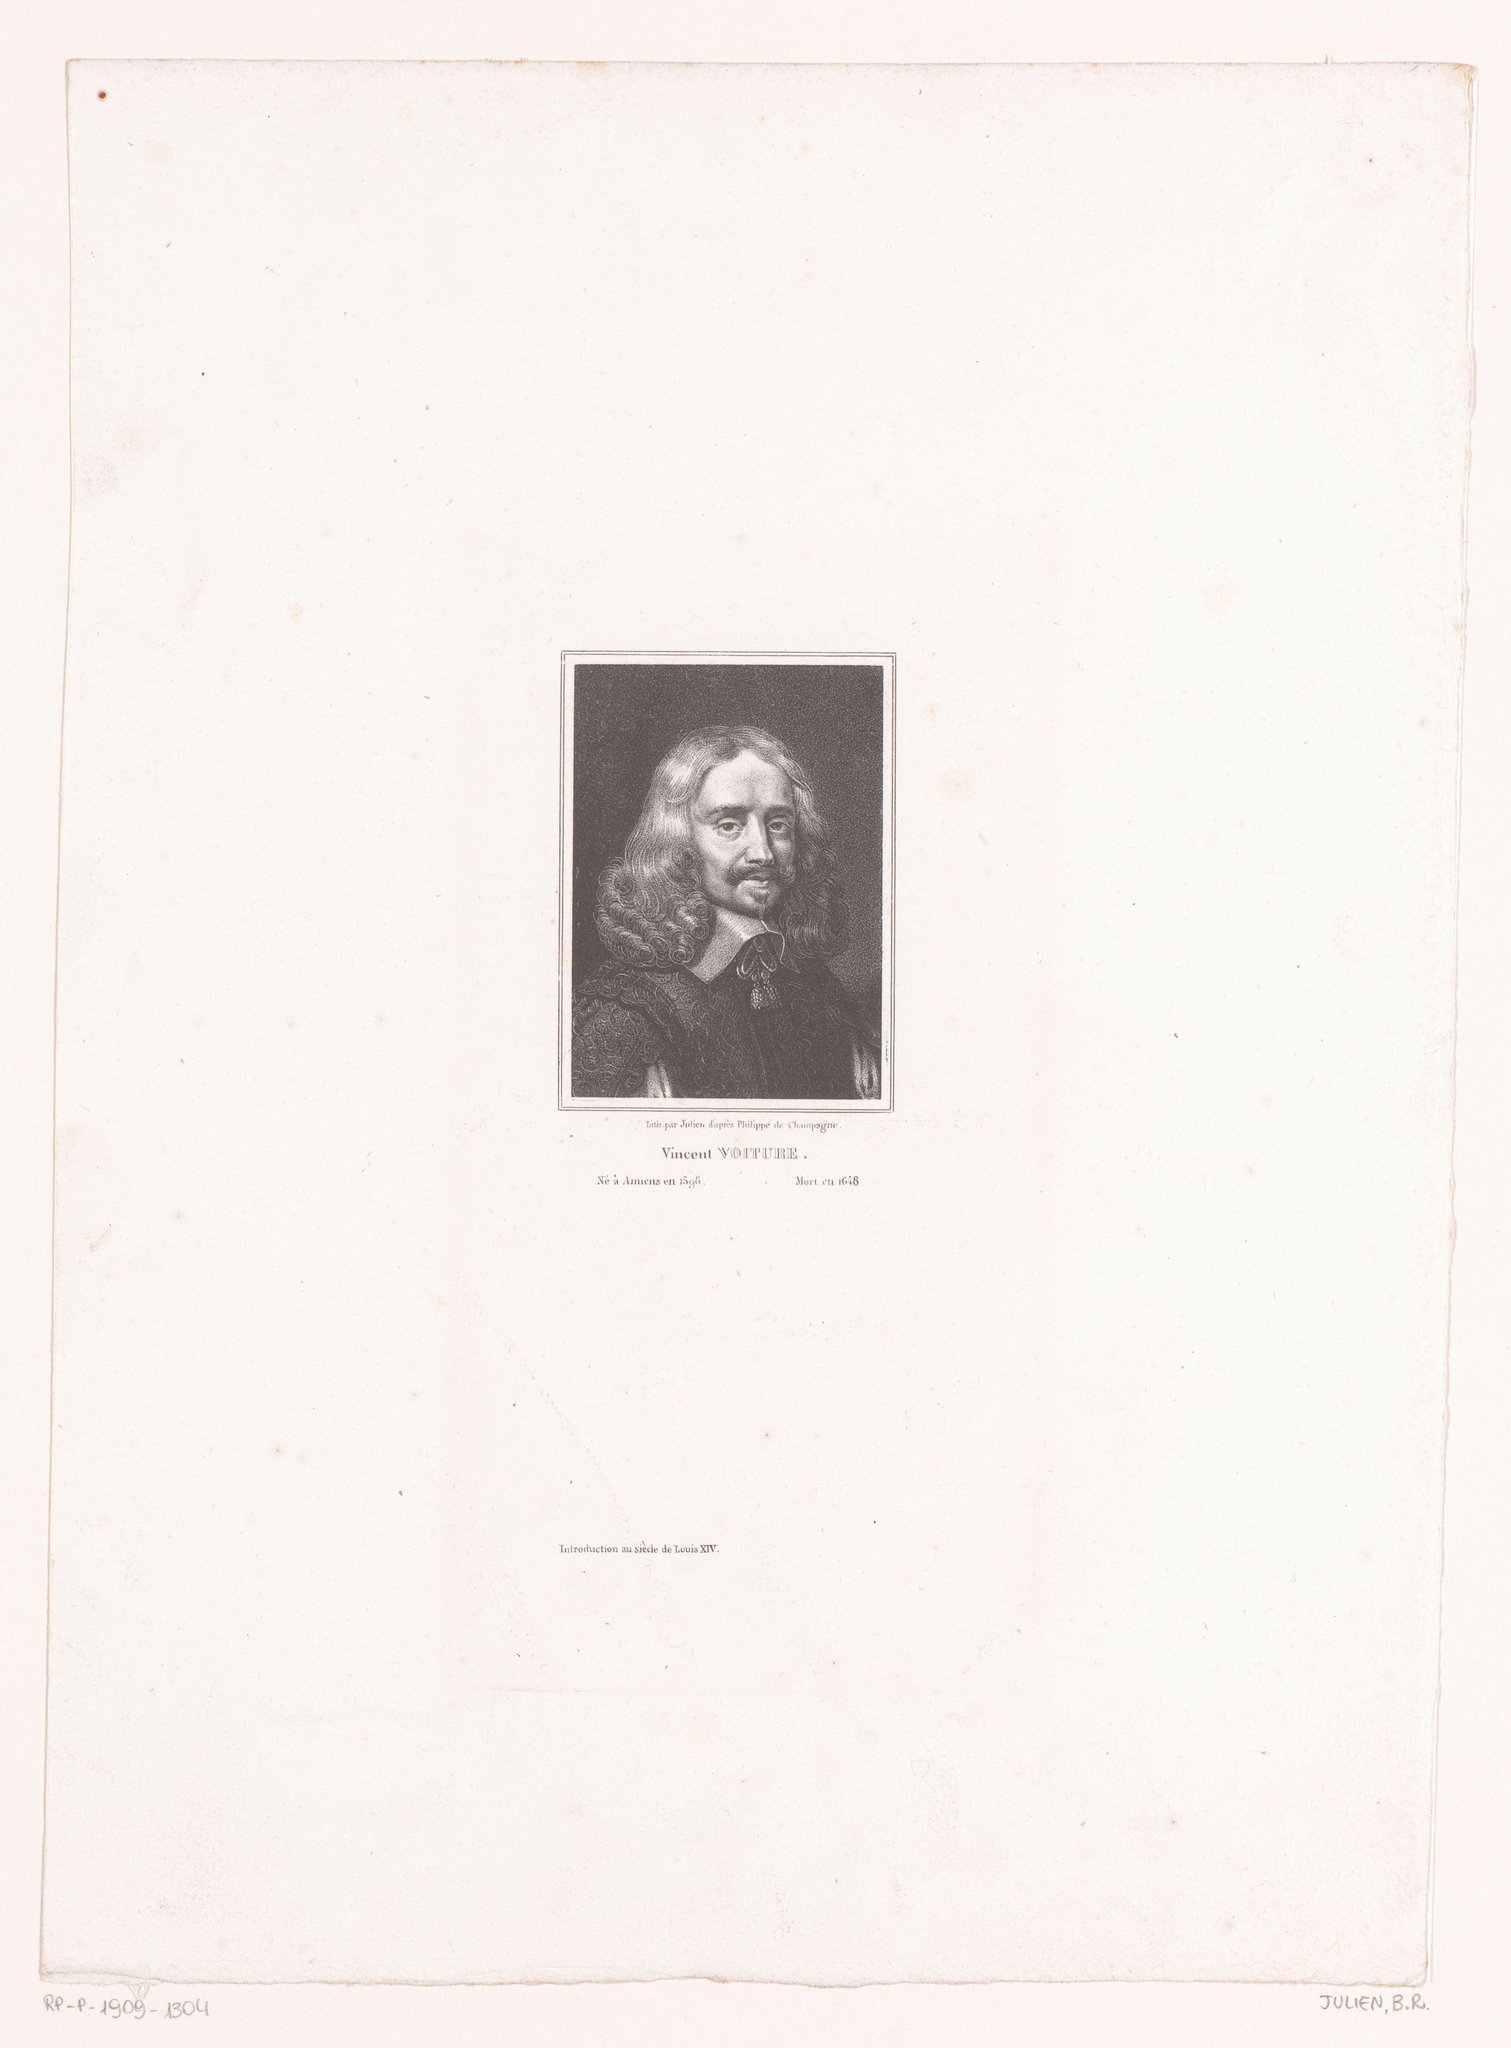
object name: print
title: Portrettengalerij van schrijvers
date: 1830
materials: paper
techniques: lithograph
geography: paris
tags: paris, historical persons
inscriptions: collector's mark: Lugt 2228a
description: Prent gebruikt voor: Illustrations du Cours de Littérature de la Harpe, ou collection de 400 portraits destinés à l'ornement de cet ouvrage. Parijs: Boblet, 1830.